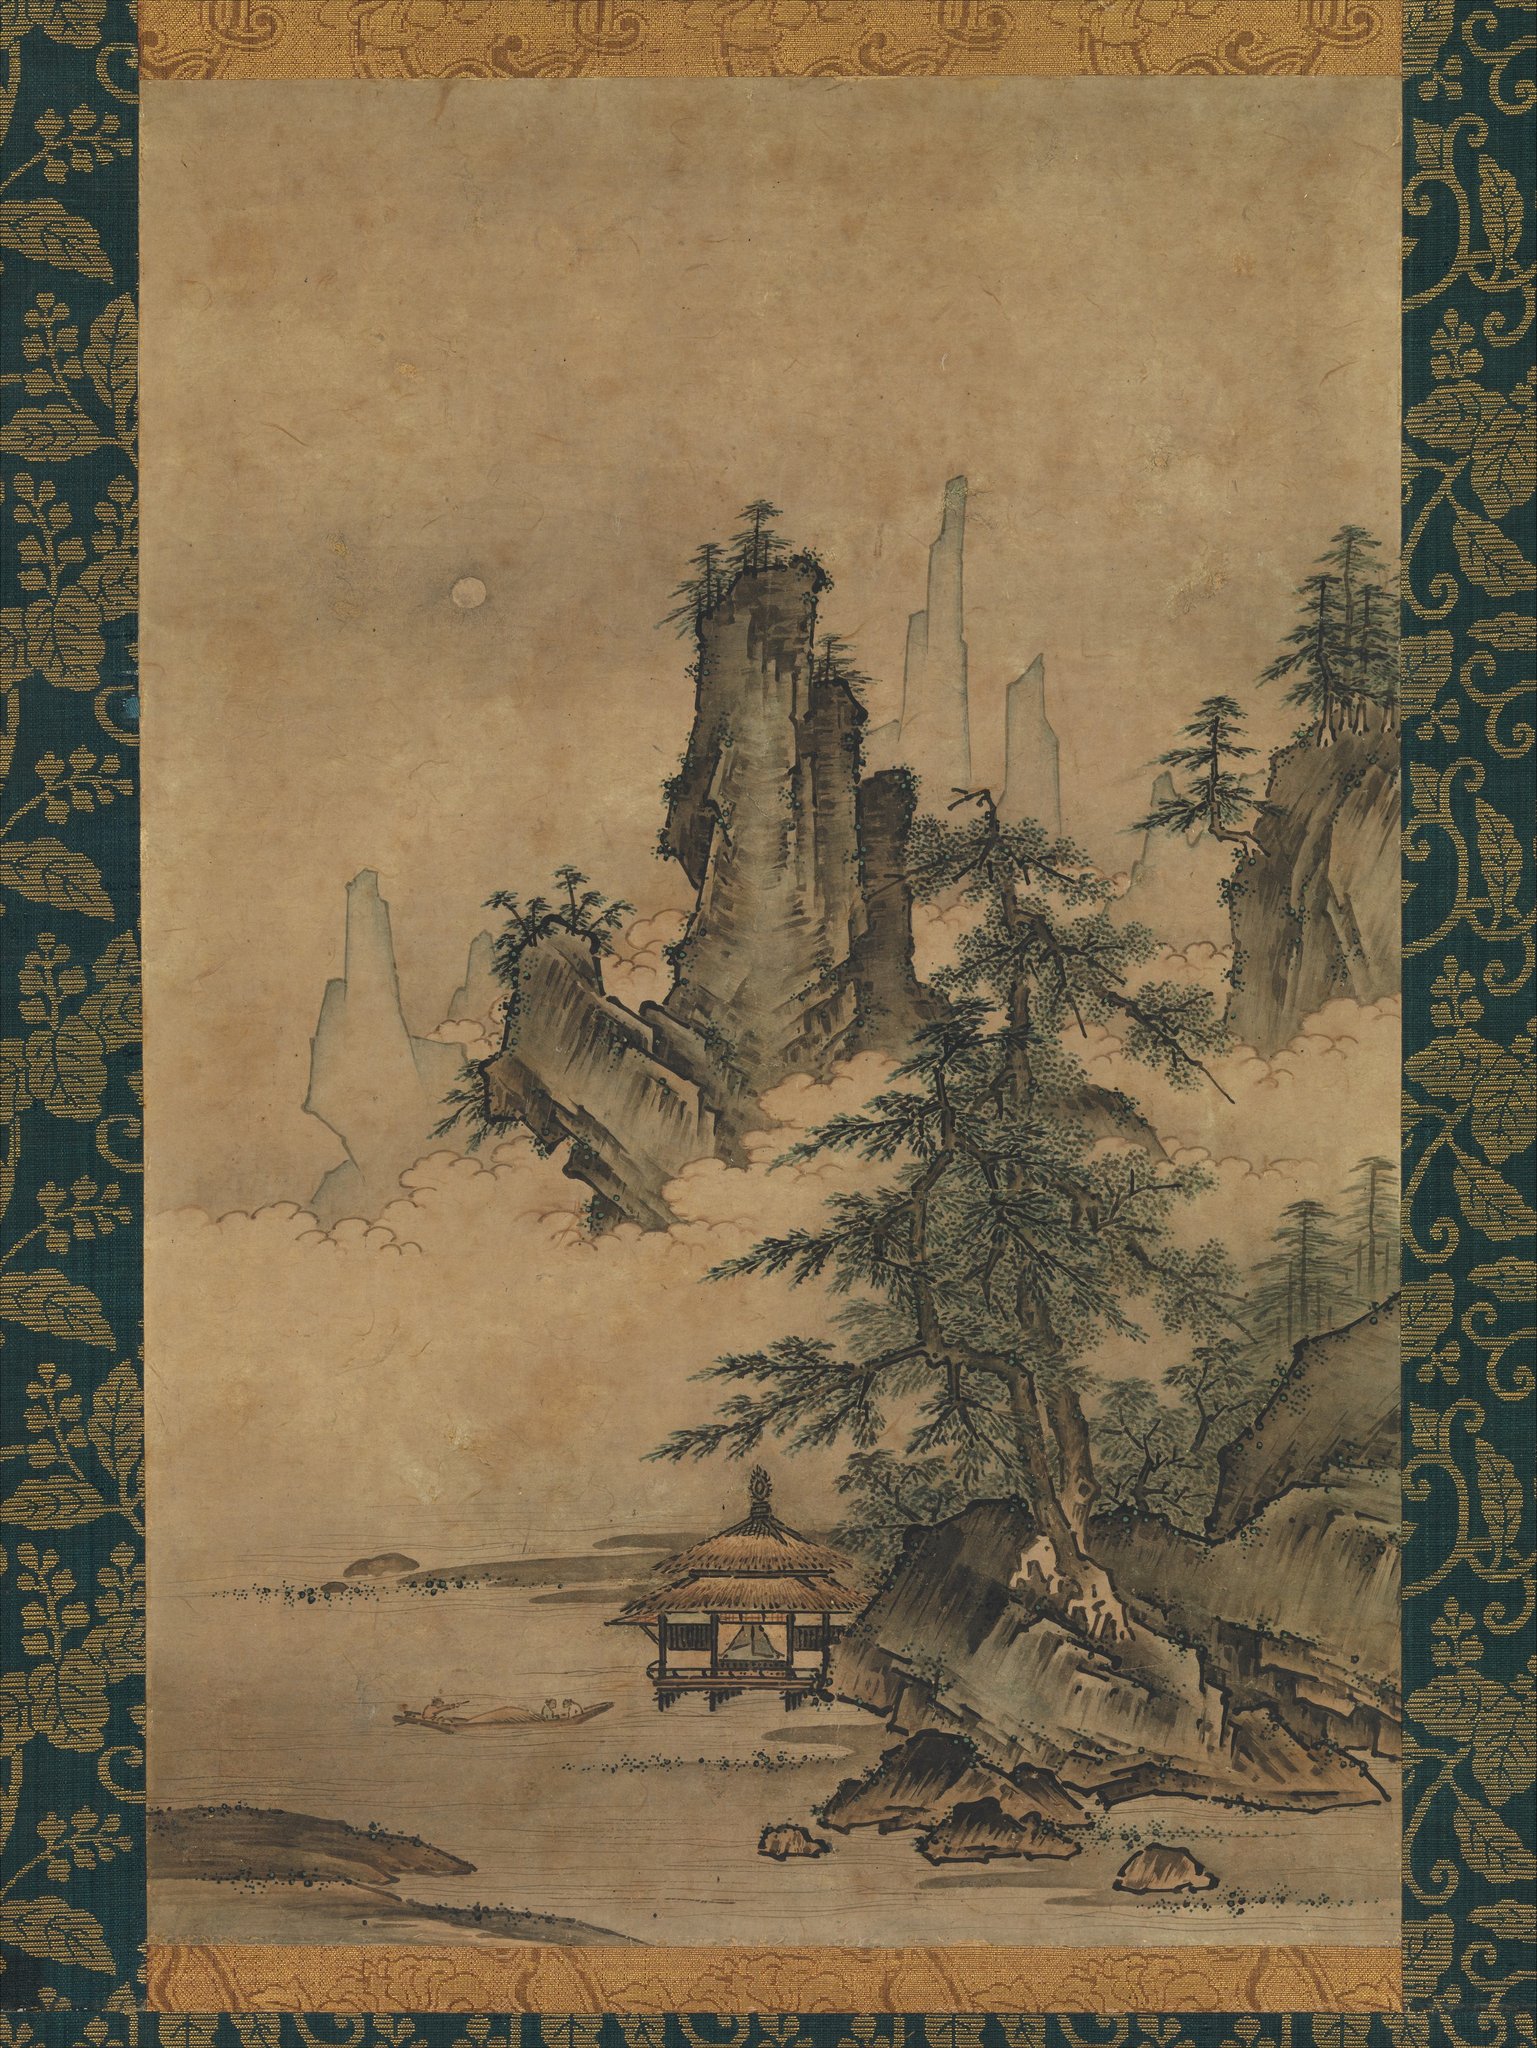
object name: hanging scroll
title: Landscape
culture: japanese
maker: maejima sōyū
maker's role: artist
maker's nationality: japanese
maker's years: 1536-1570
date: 1501-1600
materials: ink, paper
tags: mountains,landscapes,boats